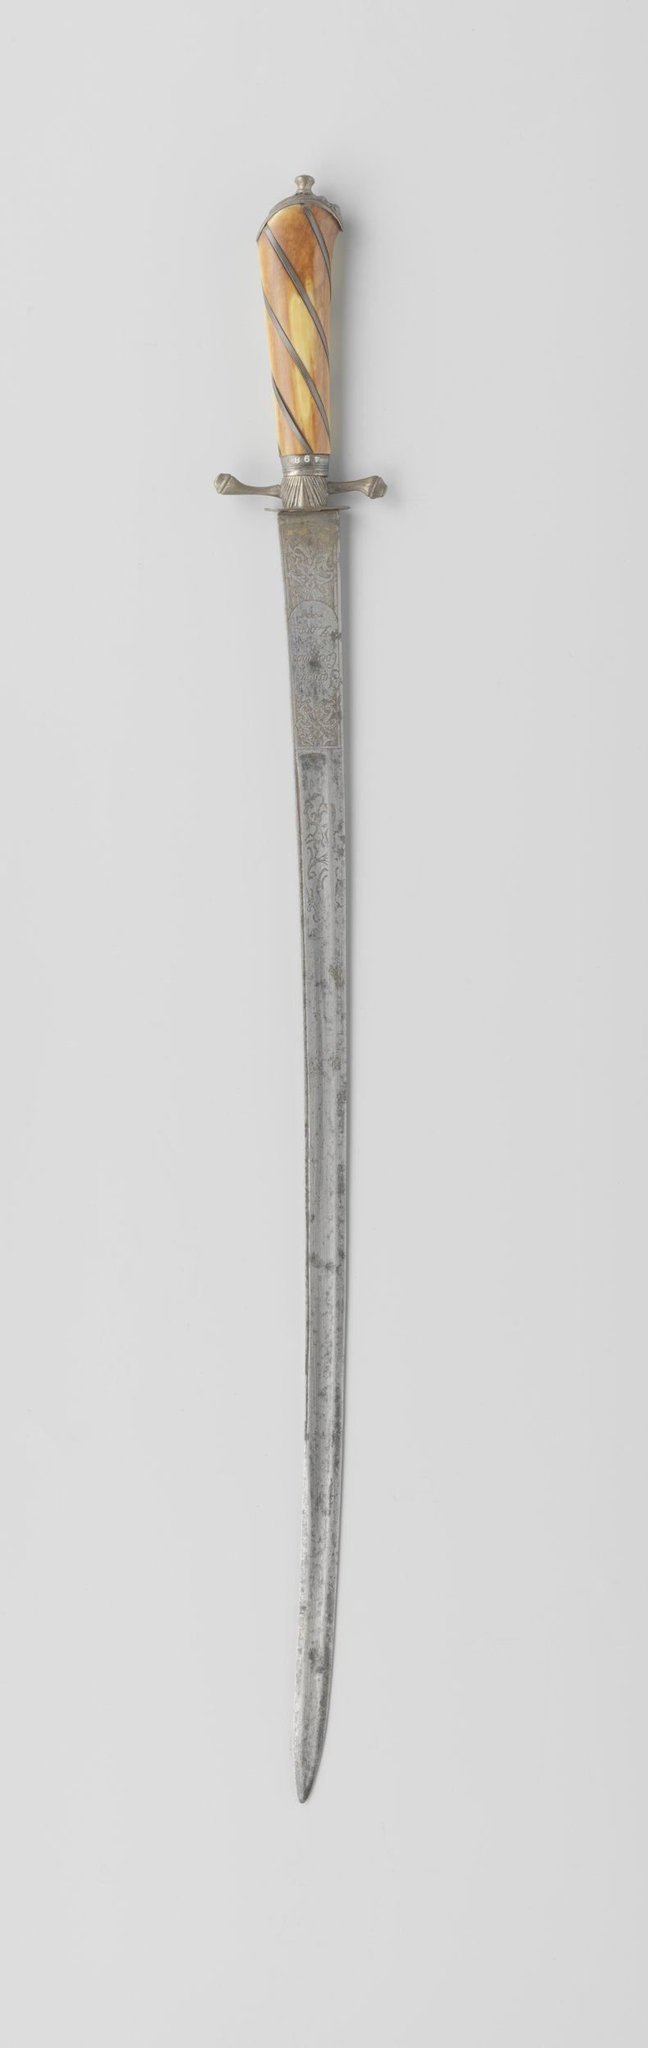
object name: hunting hanger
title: Hunting hanger owned by Rear Admiral J.A. Zoutman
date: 1774-1790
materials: bone, iron, silver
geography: amsterdam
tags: the hague, johan arnold zoutman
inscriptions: inscription: ‘over de / Trappen/ van de/ Beurs/ Tot/ Amsterdam’, name: ‘Jacobus/ Coenraads/& /Zoon’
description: A hunting hanger with a straight blade was used to deliver the final blow to cornered or wounded game. The hanger’s convenient format and often fine execution also made it popular outside the world of hunting. The deer, the wild boar and the hounds on the blade of this sword are clear references to the hunt.